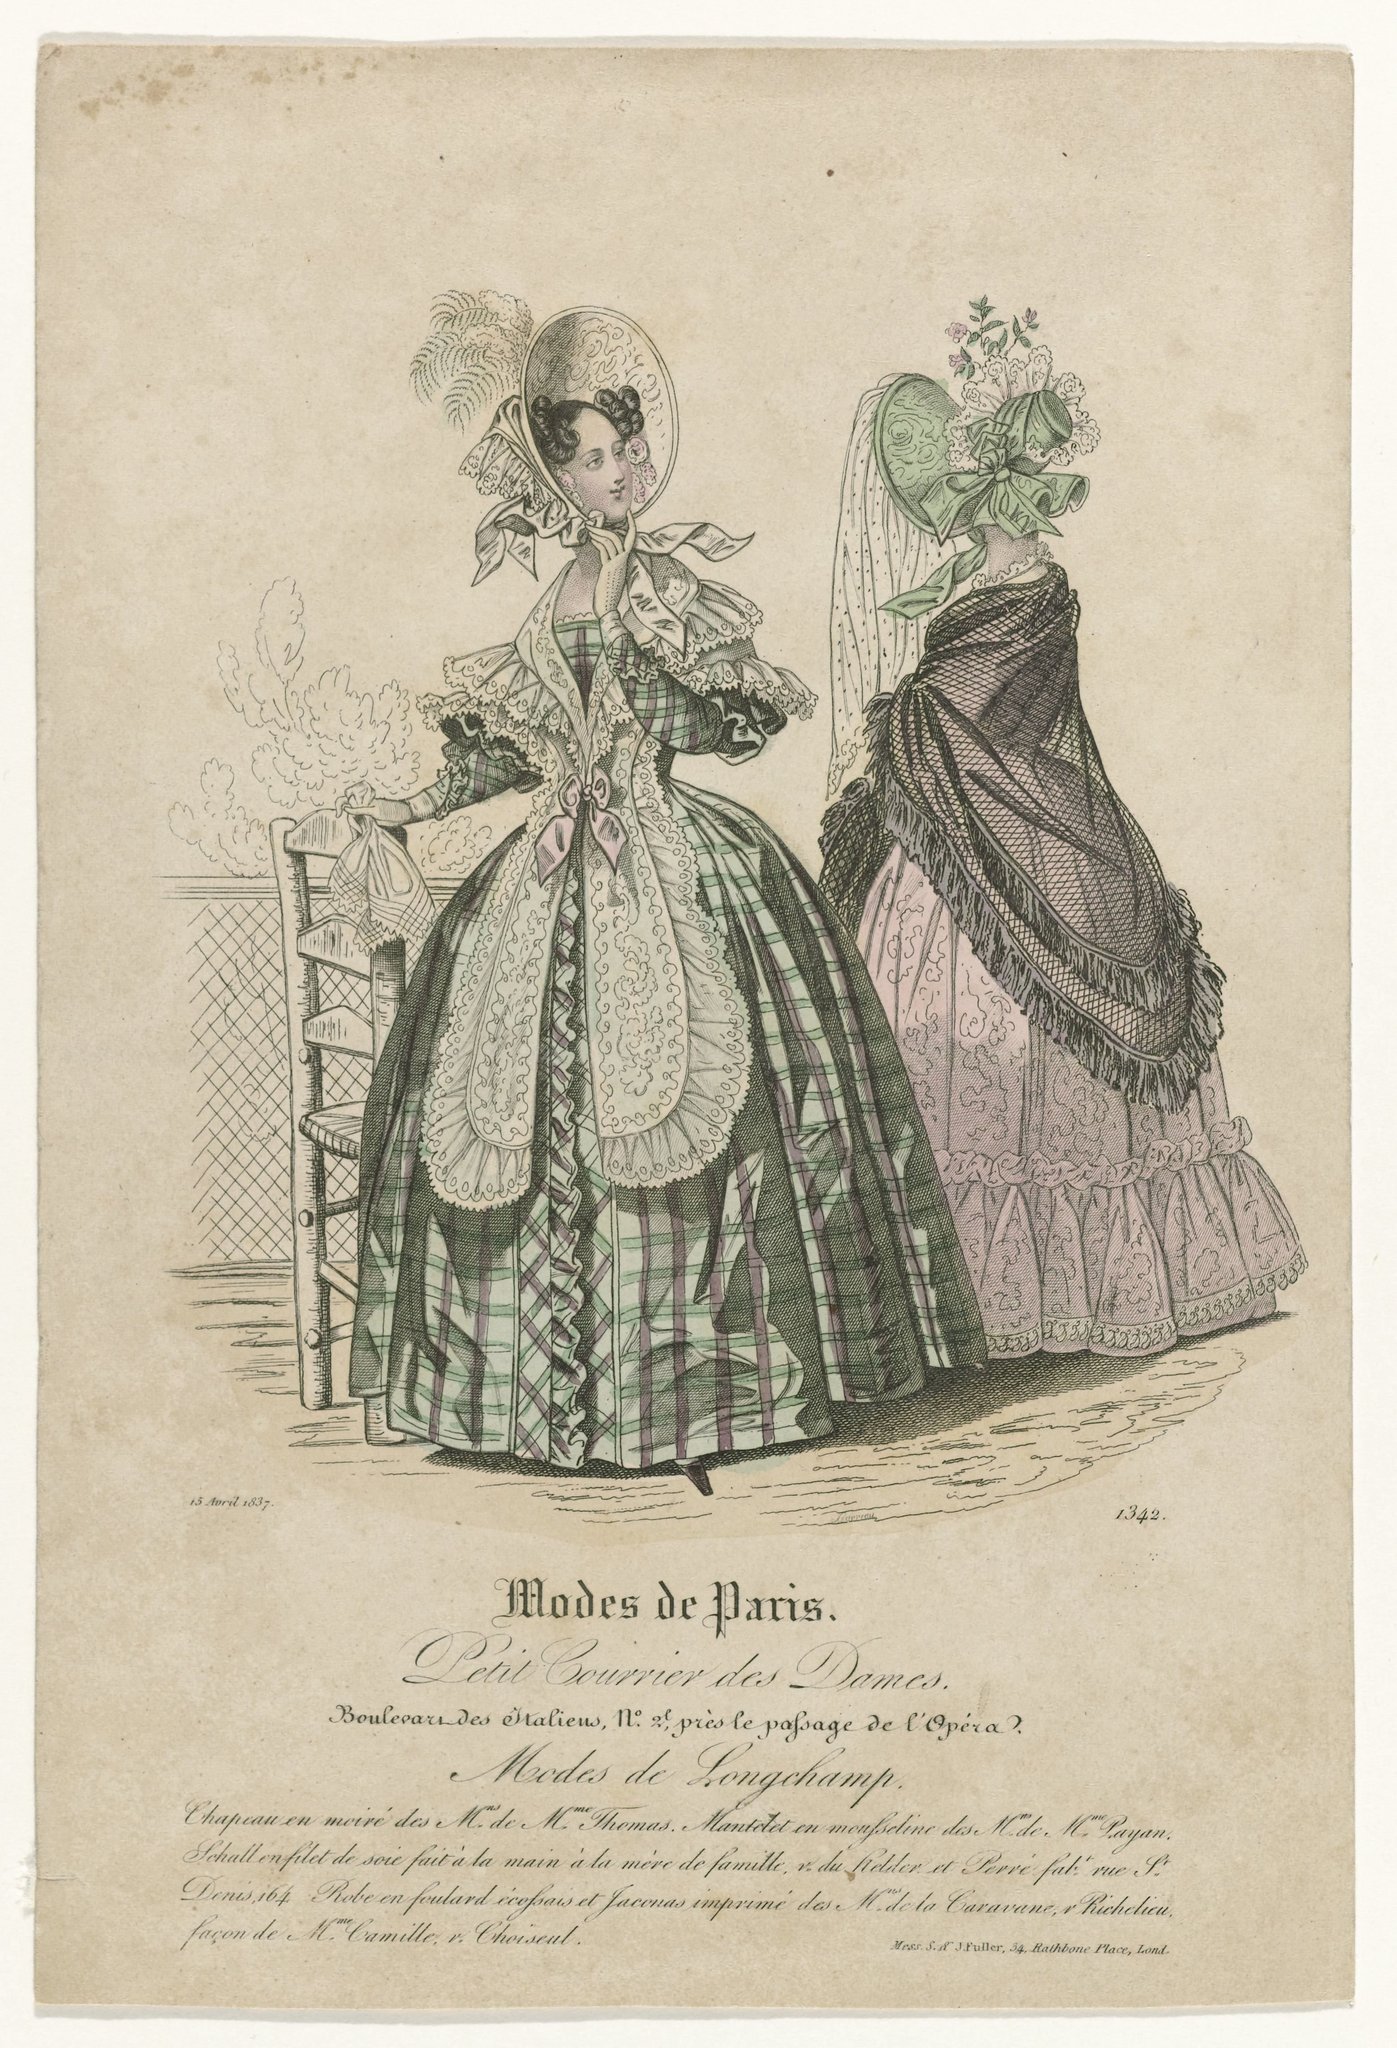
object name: fashion print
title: Petit Courrier des Dames, 15 avril 1837, No. 1342 : Modes de Longchamp (...)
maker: Anonymous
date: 1837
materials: paper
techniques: engraving, hand coloring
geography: london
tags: clothing for the upper part of the body (shawl) (+ women's clothes), veil (+ women's clothes), clothing for the upper part of the body (mantelet) (+ women's clothes), fashion plates, head-gear: hat (+ women's clothes), dress, gown (+ women's clothes)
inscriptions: address: ‘Boulevart des Italiens, No. 2l, près le passage de l'Opéra.’, caption: ‘Modes de Longchamp / Chapeau en moiré des Mns de Mme Thomas. Mantelet en mousseline des Mme Payan. Schall en filet de soie fait à la main à la mère de famille, r. du helder et Perré fabt rue St Denis, 164 Robe en foulard écossais et jconas iimprimé des Mns de la Caravane, r Richelieu, façon de Mme Camille , r. Choiseul.’, title: ‘Modes de Paris. / Petit Courrier des Dames’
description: Hoed van moiré (zijde?) uit de winkels van Thomas. 'Mantelet' van mousseline uit de winkels van Mme Payan. Sjaal van 'filet de soie' handgemaakt door de huismoeder. Japon van schots geruite foulard en bedrukte jaconas uit de winkels van Caravane, uitgevoerd op de manier van Mme Camille. Prent uit het modetijdschrift Petit Courrier des Dames (1821-1868).